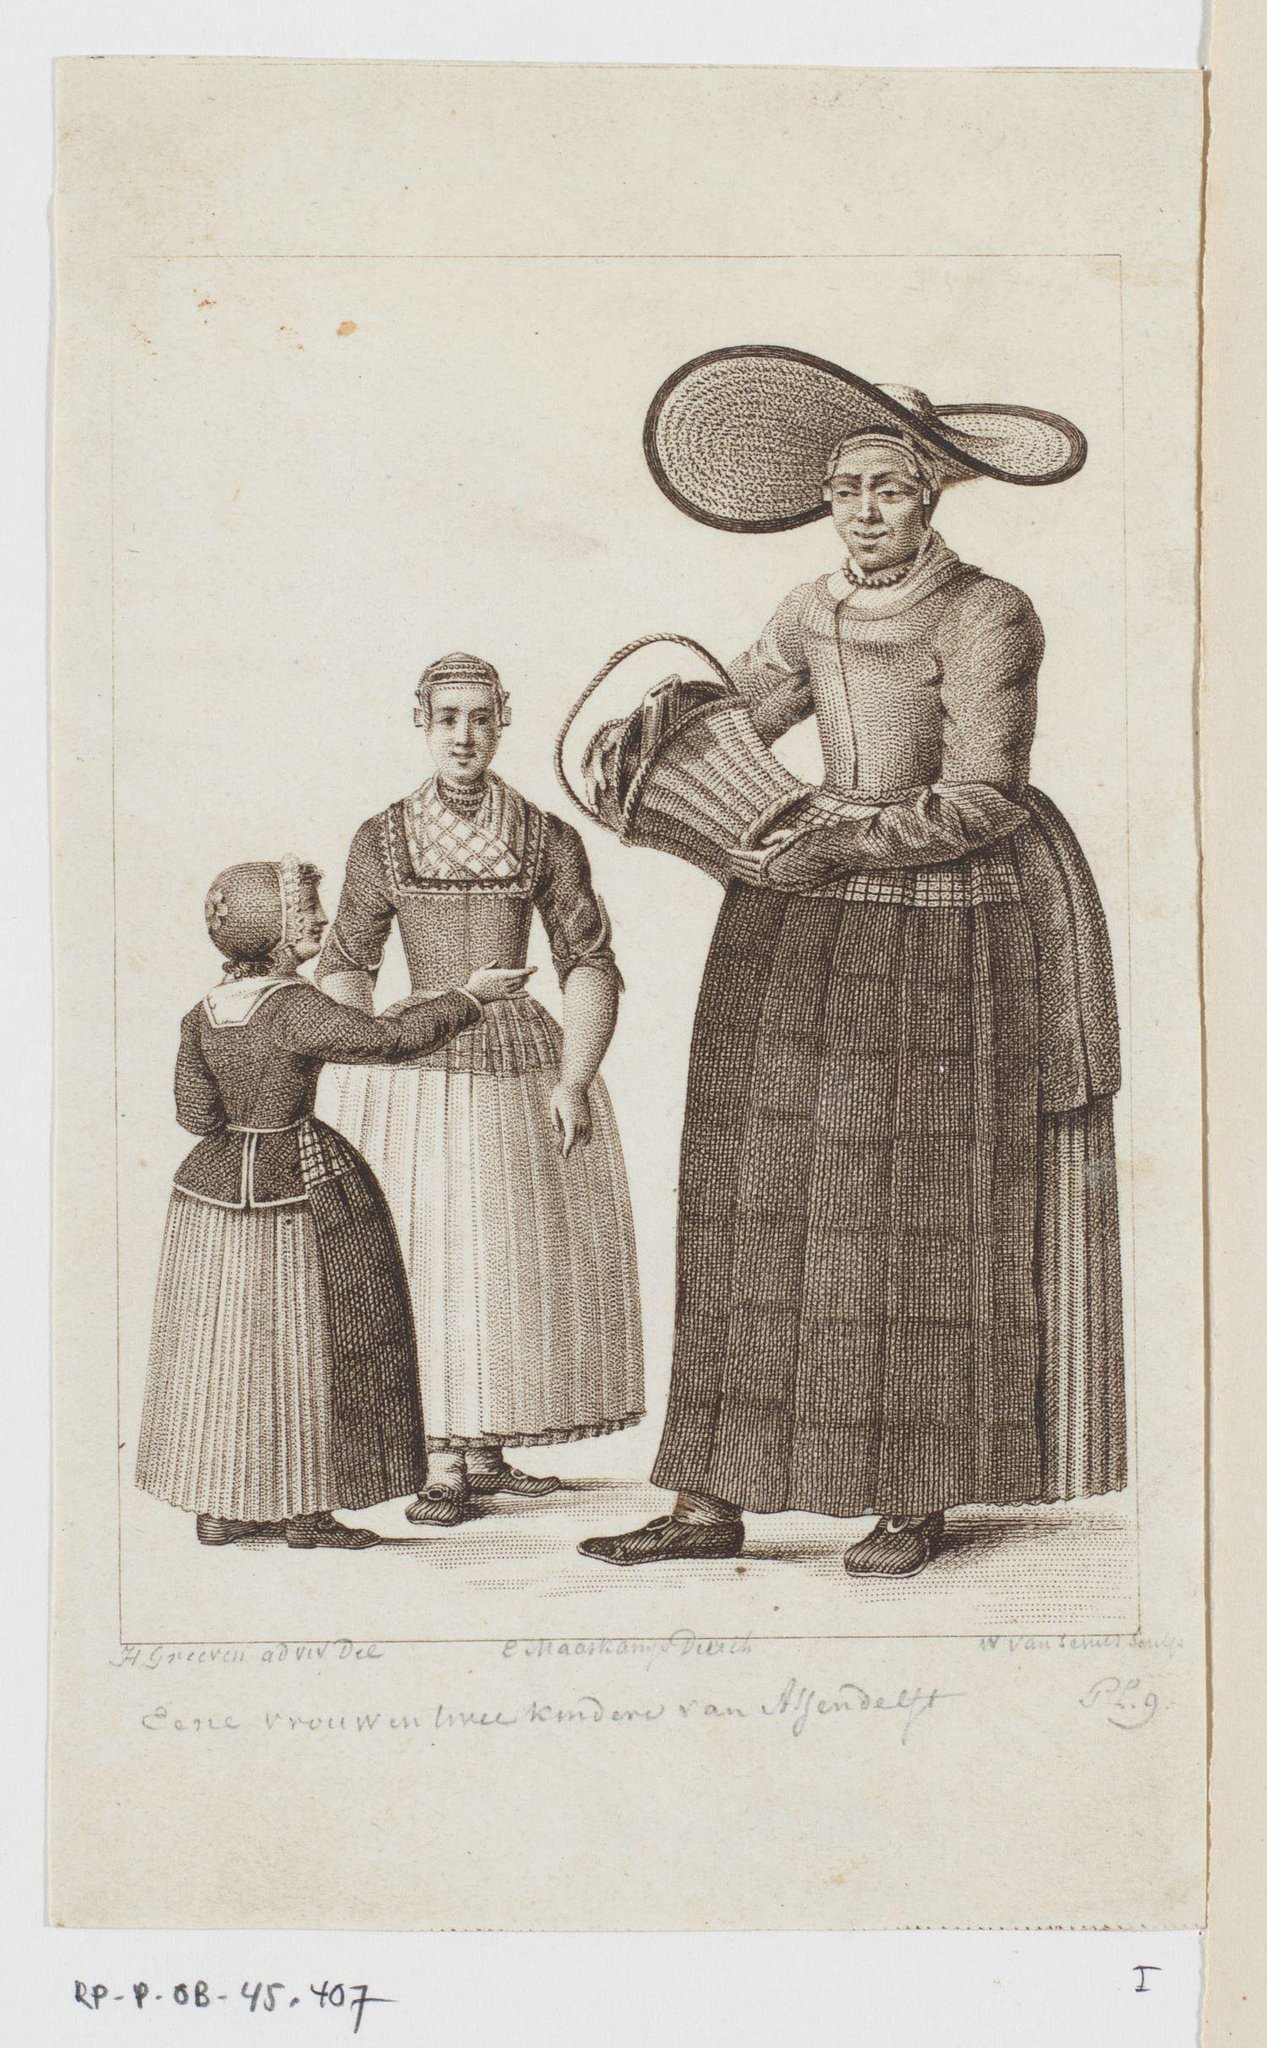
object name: print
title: Vrouw en twee kinderen uit Assendelft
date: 1824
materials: paper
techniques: printing, engraving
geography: netherlands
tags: folk costume, regional costume, mother and daughter(s) (family group) (with number of daughters), assendelft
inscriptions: collector's mark: Lugt 2228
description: Latere staat prent gebruikt in: Maaskamp, Evert. Tableau des principales vues des palais et edifices; representations et des coutumes et usages, dans les Provinces Septentrionales du Royaume des Pays-Bas. Amsterdam, 1824.